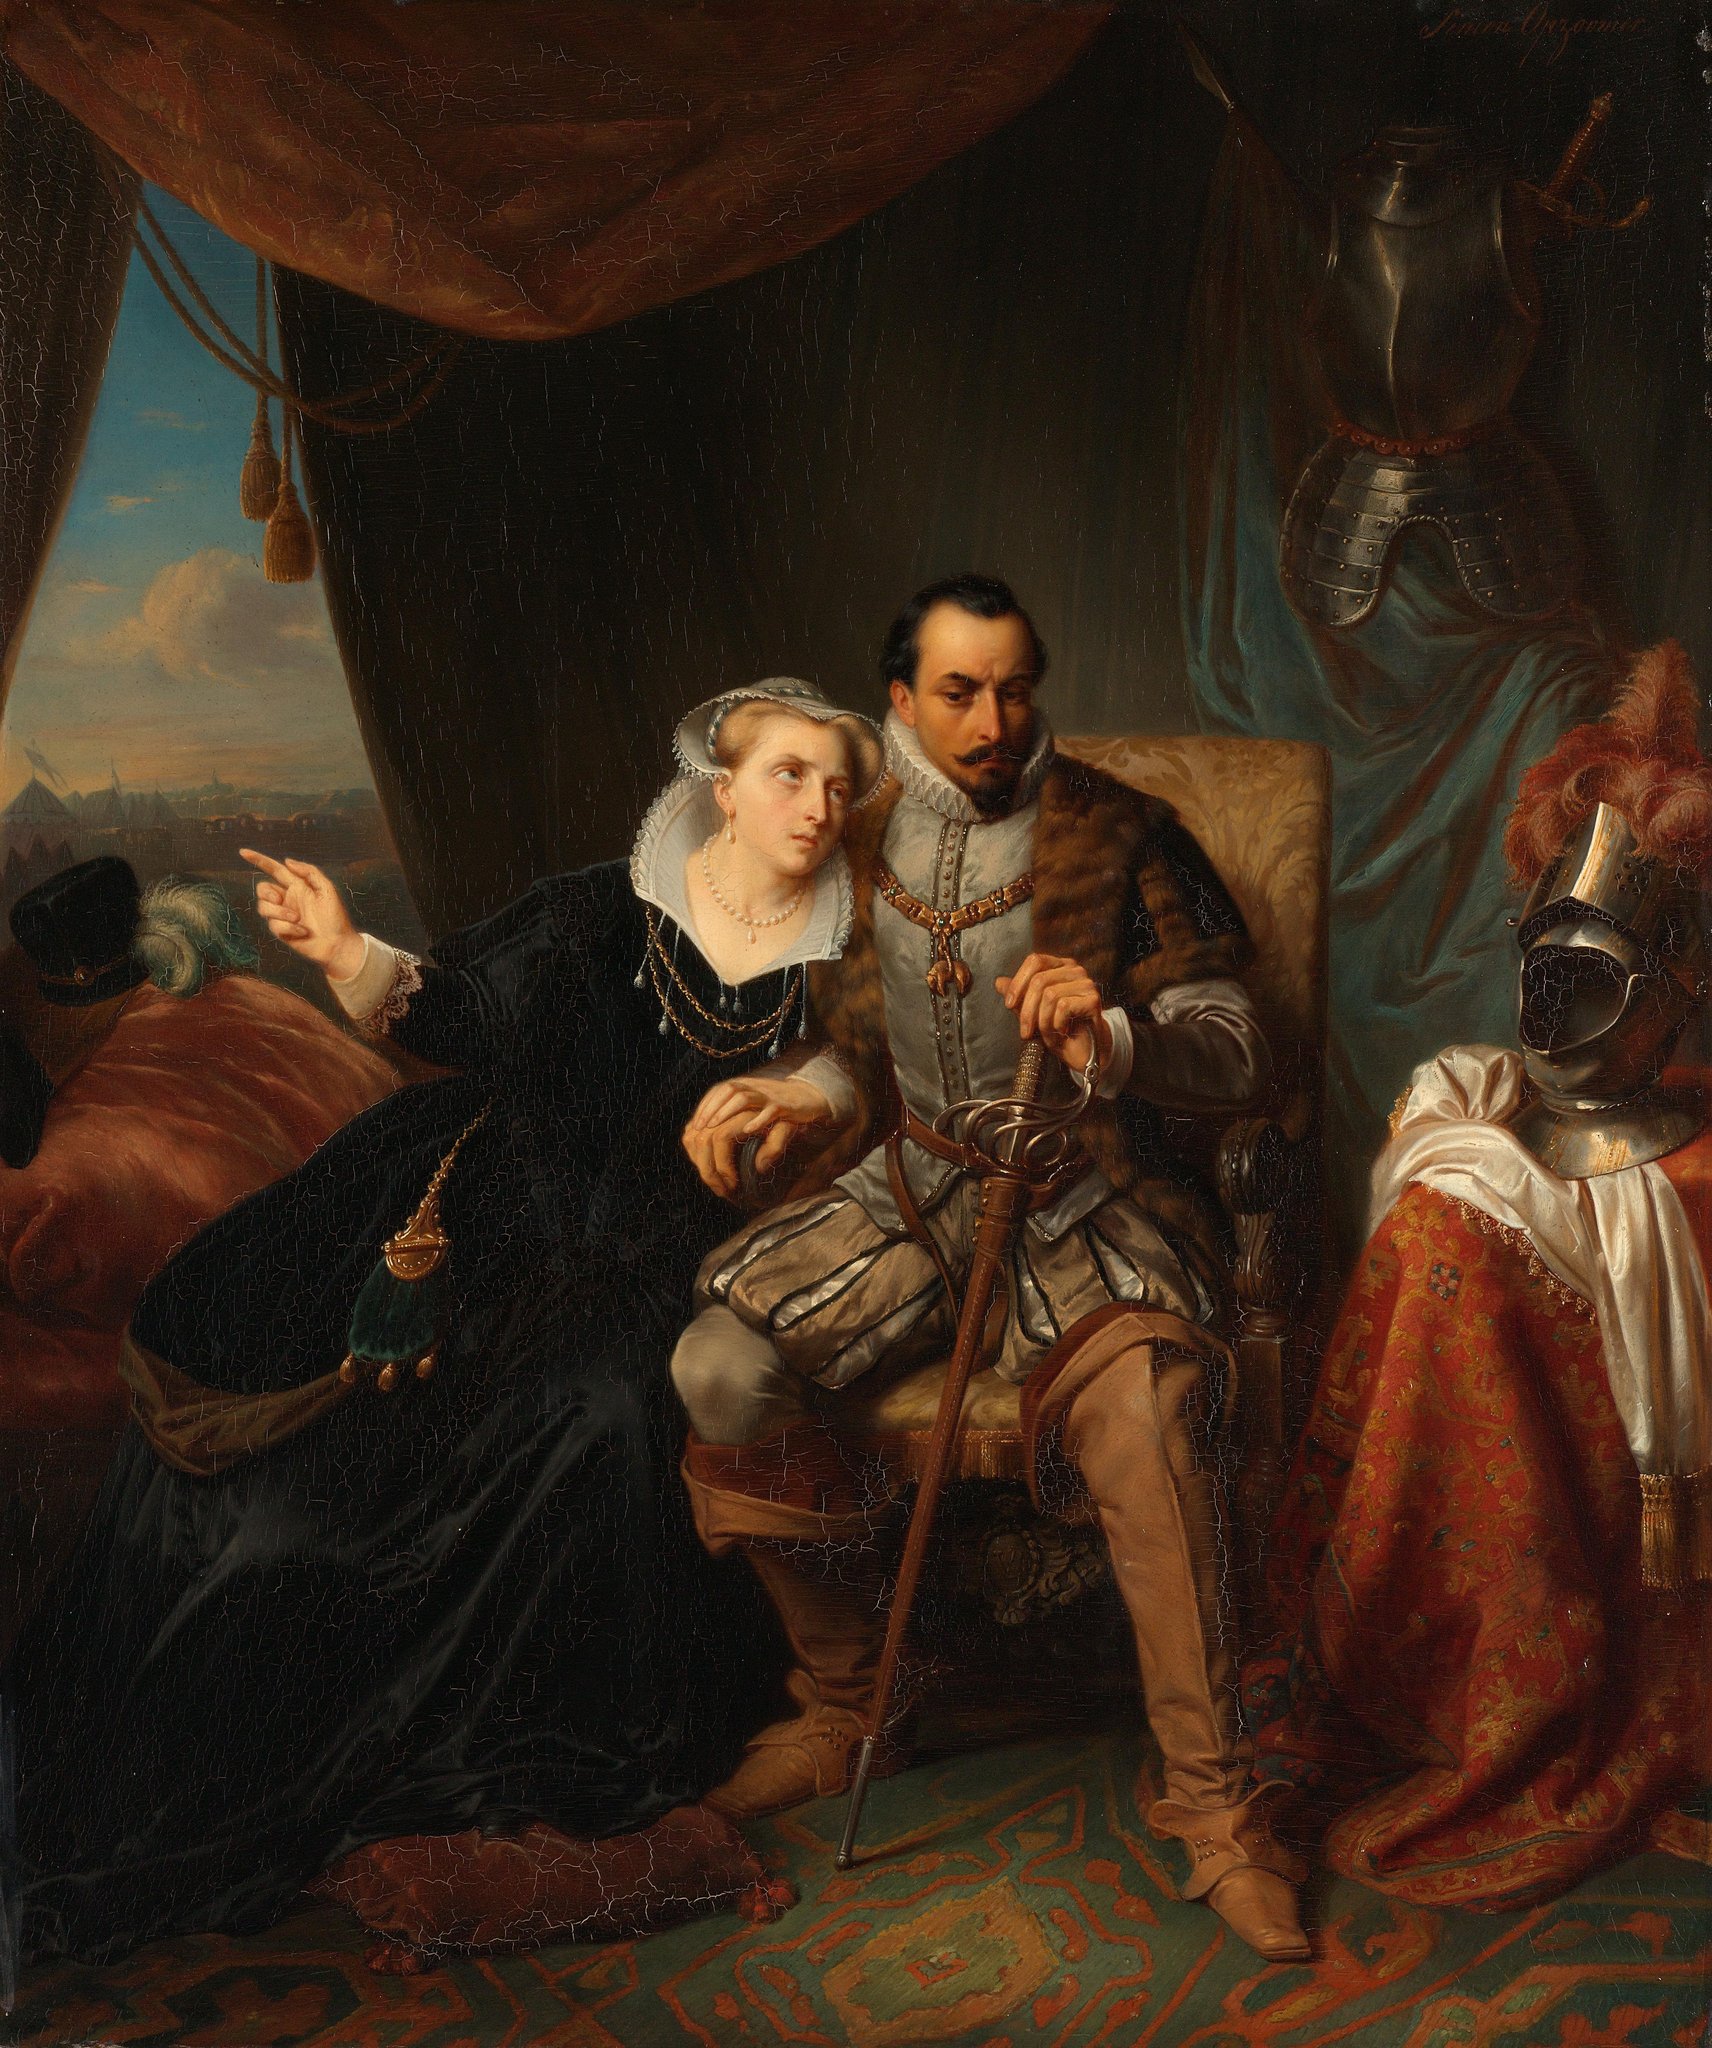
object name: painting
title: "Magdalena Moons Begs her Fiancé Francisco Valdez to Postpone the Storming of Leiden another night, 1574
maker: simon opzoomer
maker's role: painter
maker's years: 1819-1878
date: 1840-1850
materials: oil, panel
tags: the hague, utrecht, (military) camp with tents, siege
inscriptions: signature: ‘Simon Opzoomer’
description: In the spring of 1574, the inhabitants of Leiden were starving because of the long siege by the Spaniards. The Spanish general Valdez decided to invade the weakened town. His lover Magdalena Moons promised to marry him if he would wait one more night. He agreed to do so; however, that very night the land was flooded because the Beggars (resistance fighters) broke through the dykes. The Spanish troops fled and Magdalena Moons became the heroine of the Relief of Leiden.